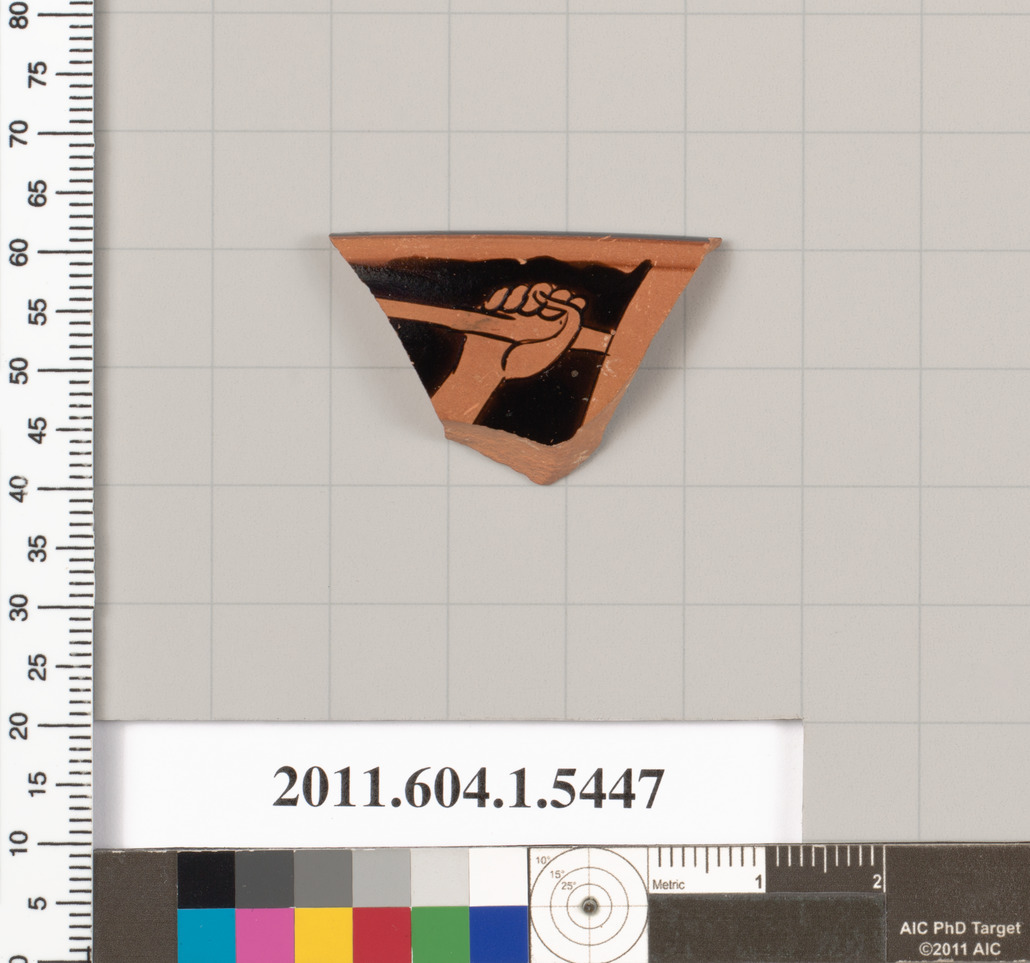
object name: kylix fragment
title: Terracotta rim fragment of a kylix (drinking cup)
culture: greek, attic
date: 500-490 BCE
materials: terracotta